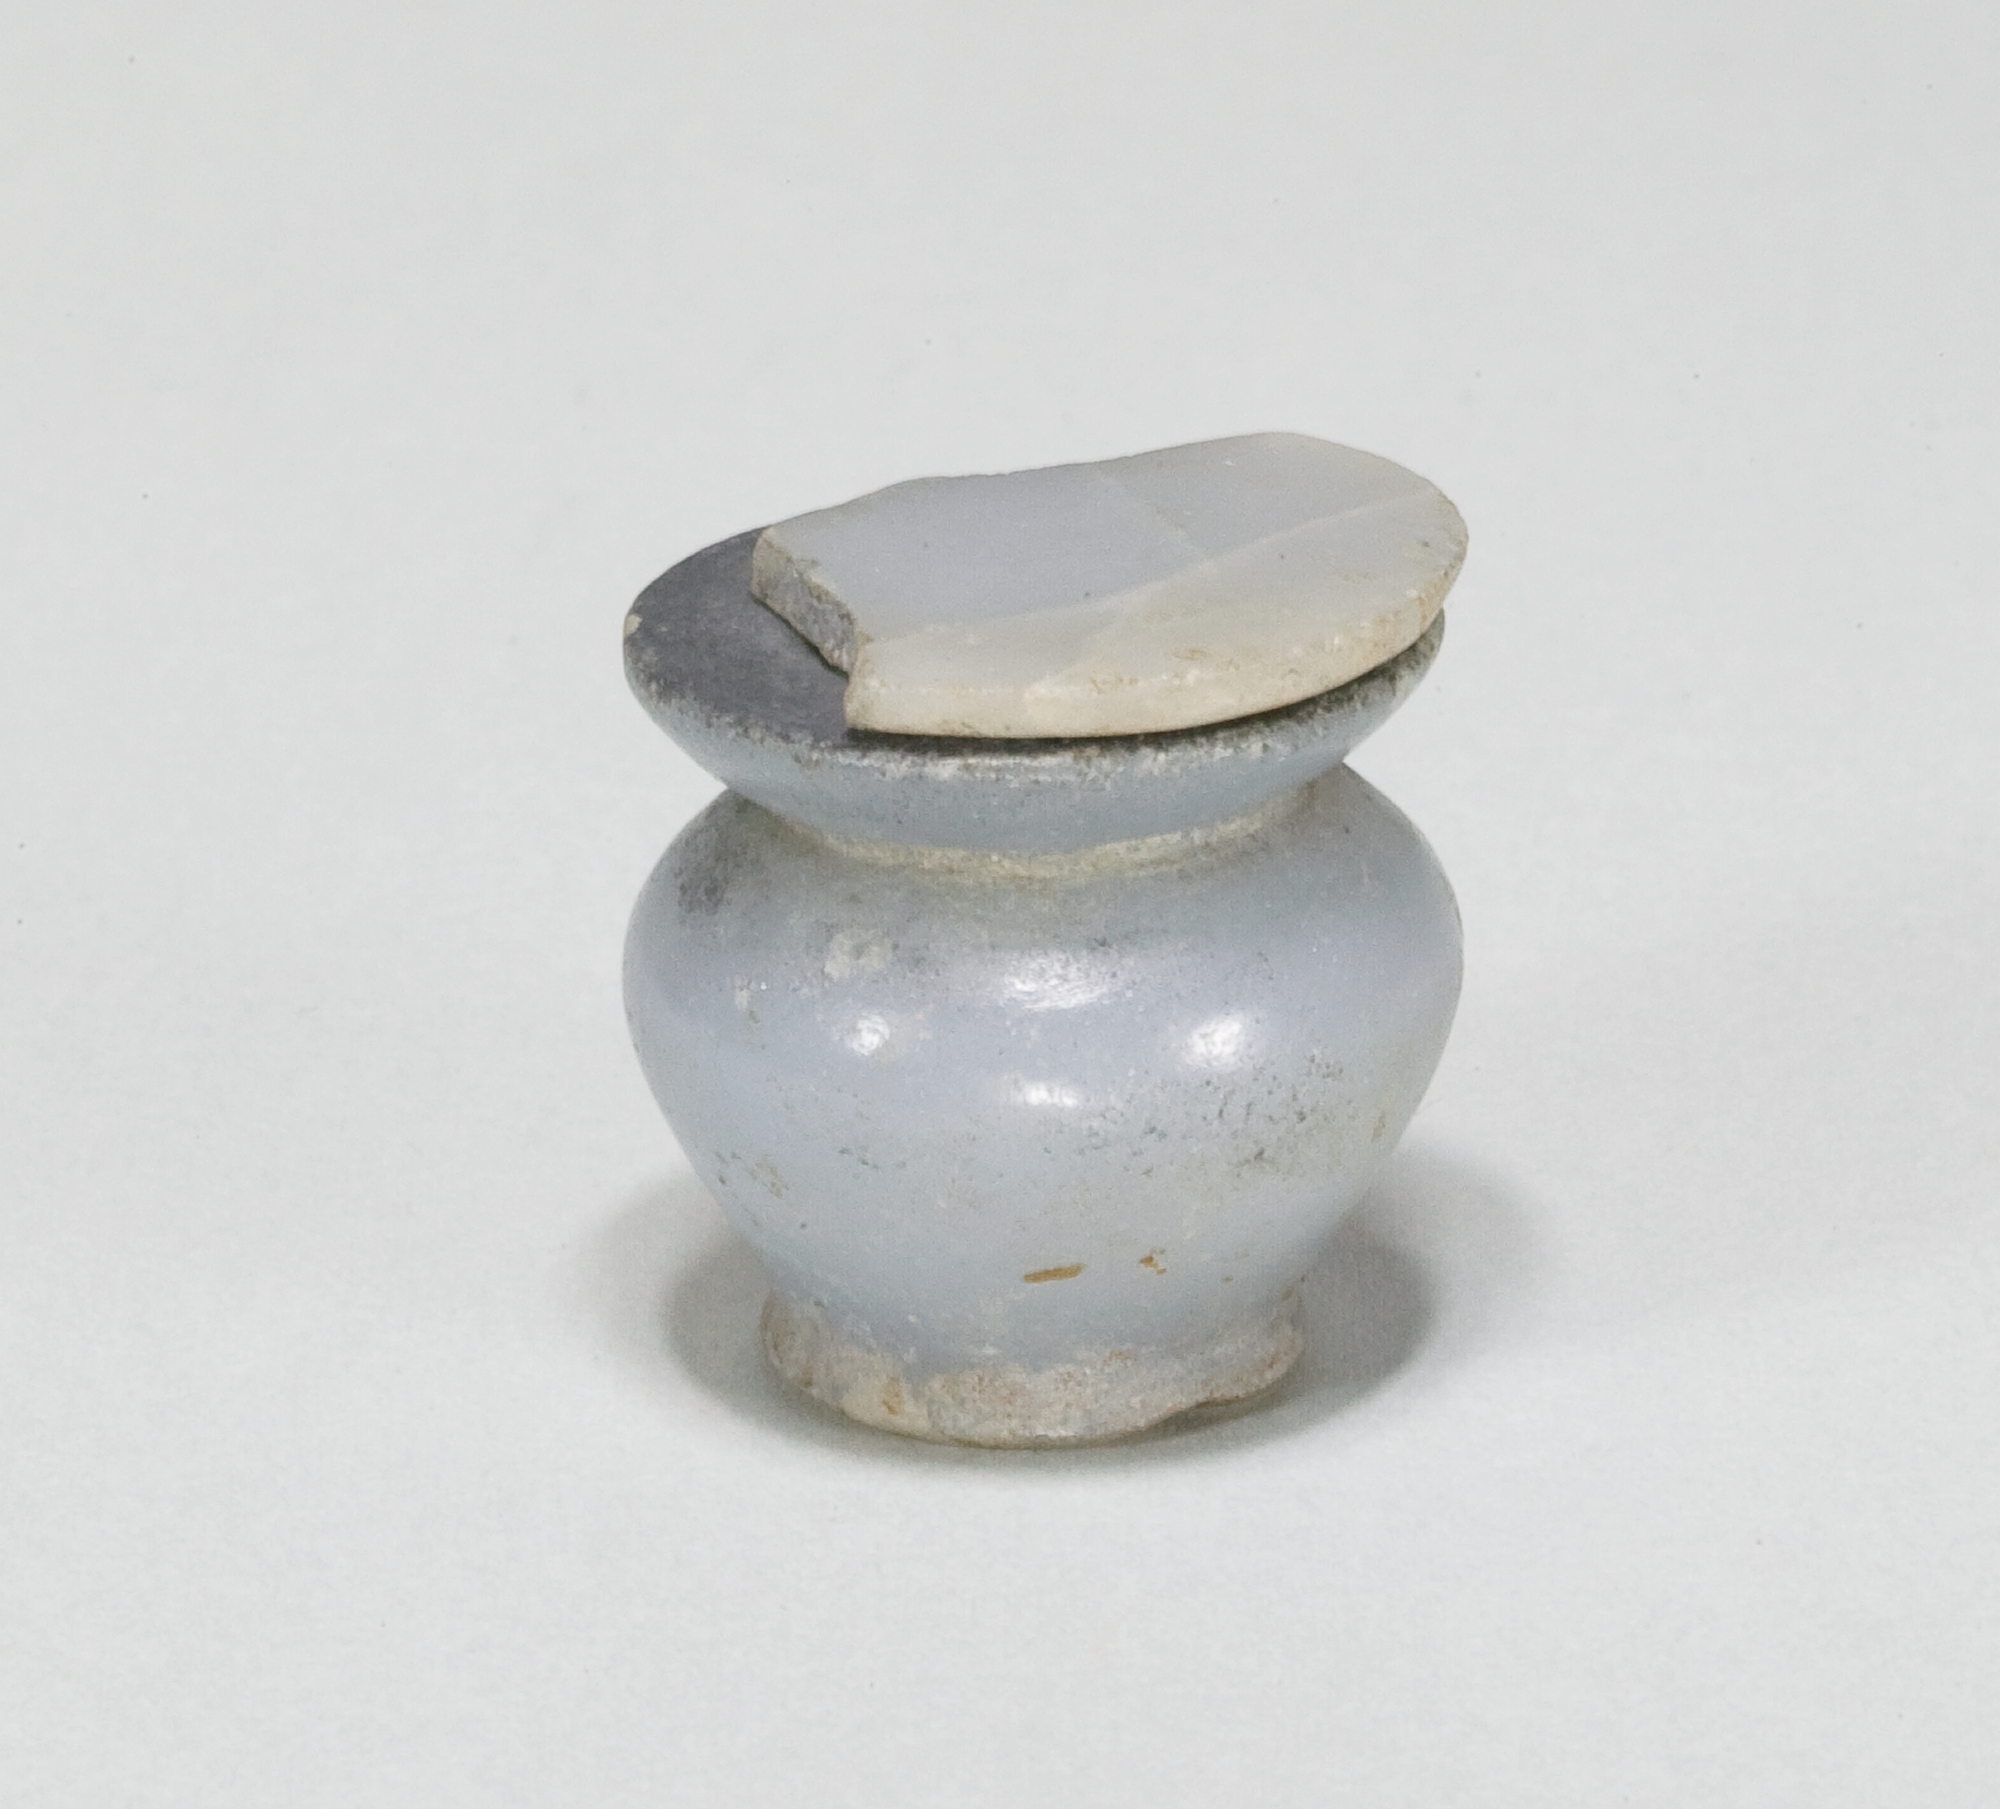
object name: kohl jar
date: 1850-1640 BCE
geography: egypt